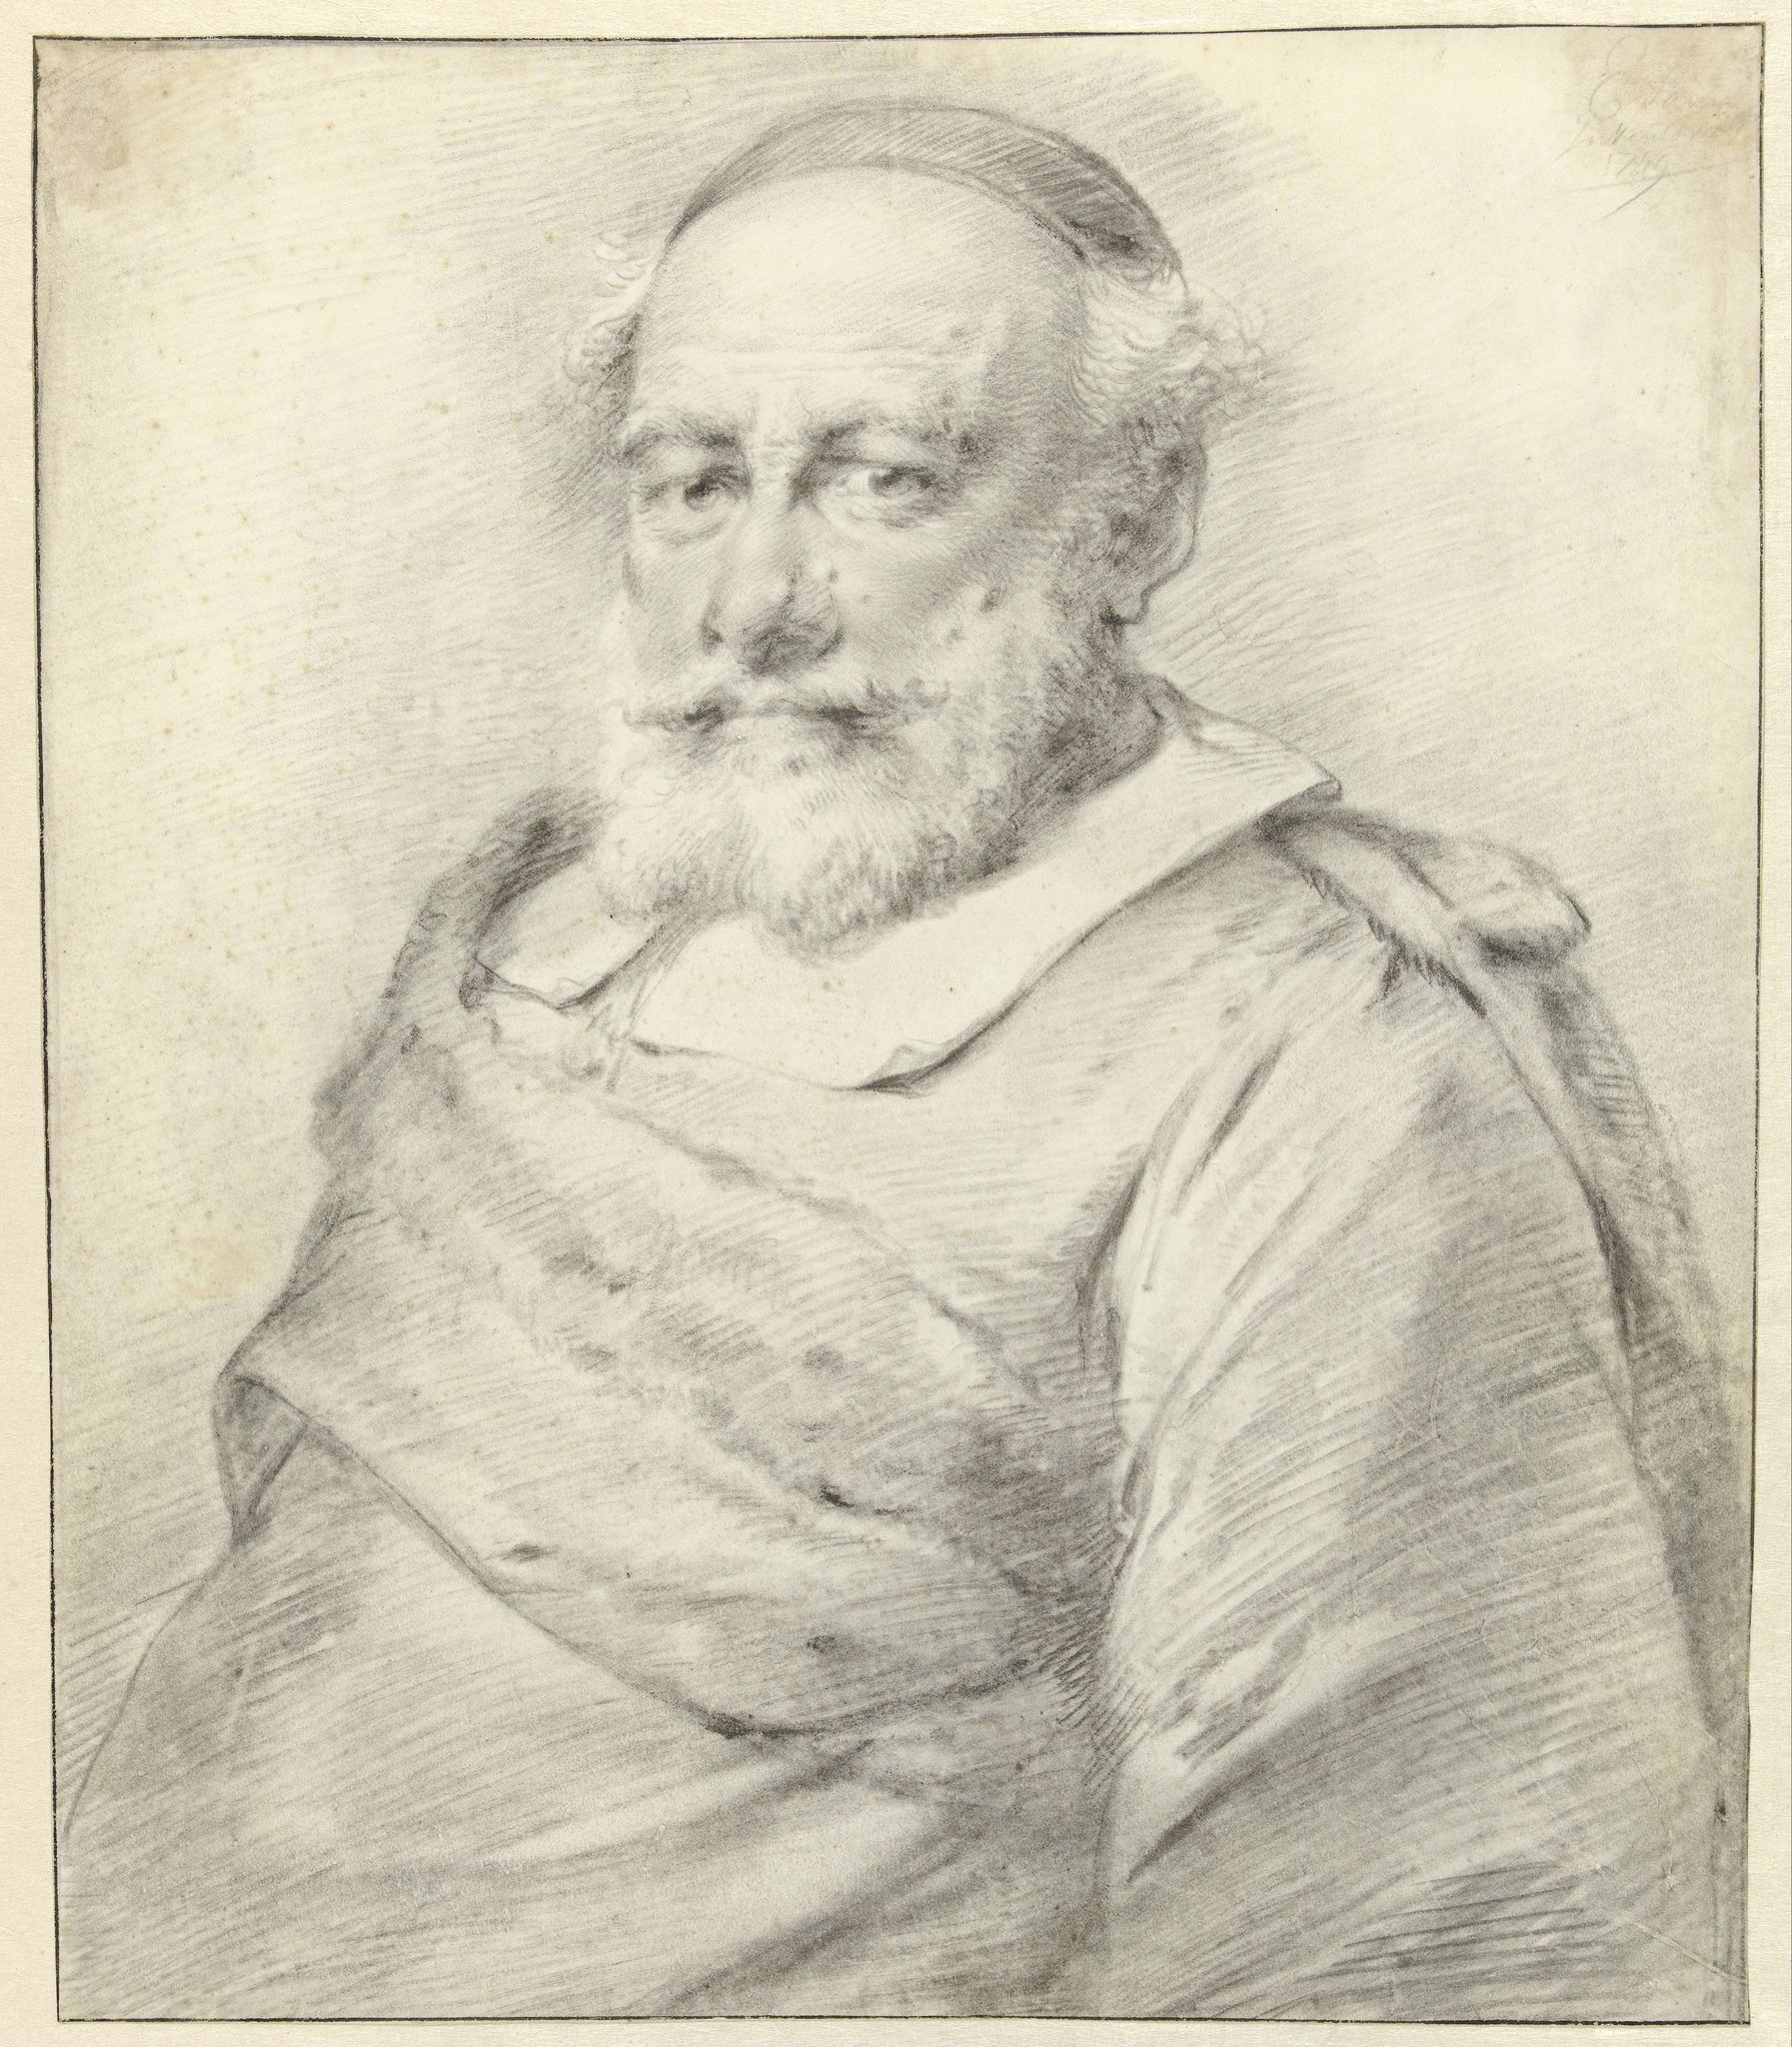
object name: drawing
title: Portret van een man met witte baard en kapje op het hoofd, naar links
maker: engel sam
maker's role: draughtsman, painter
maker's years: 1699-1769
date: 1749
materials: chalk, parchment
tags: anonymous historical person portrayed alone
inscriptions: date